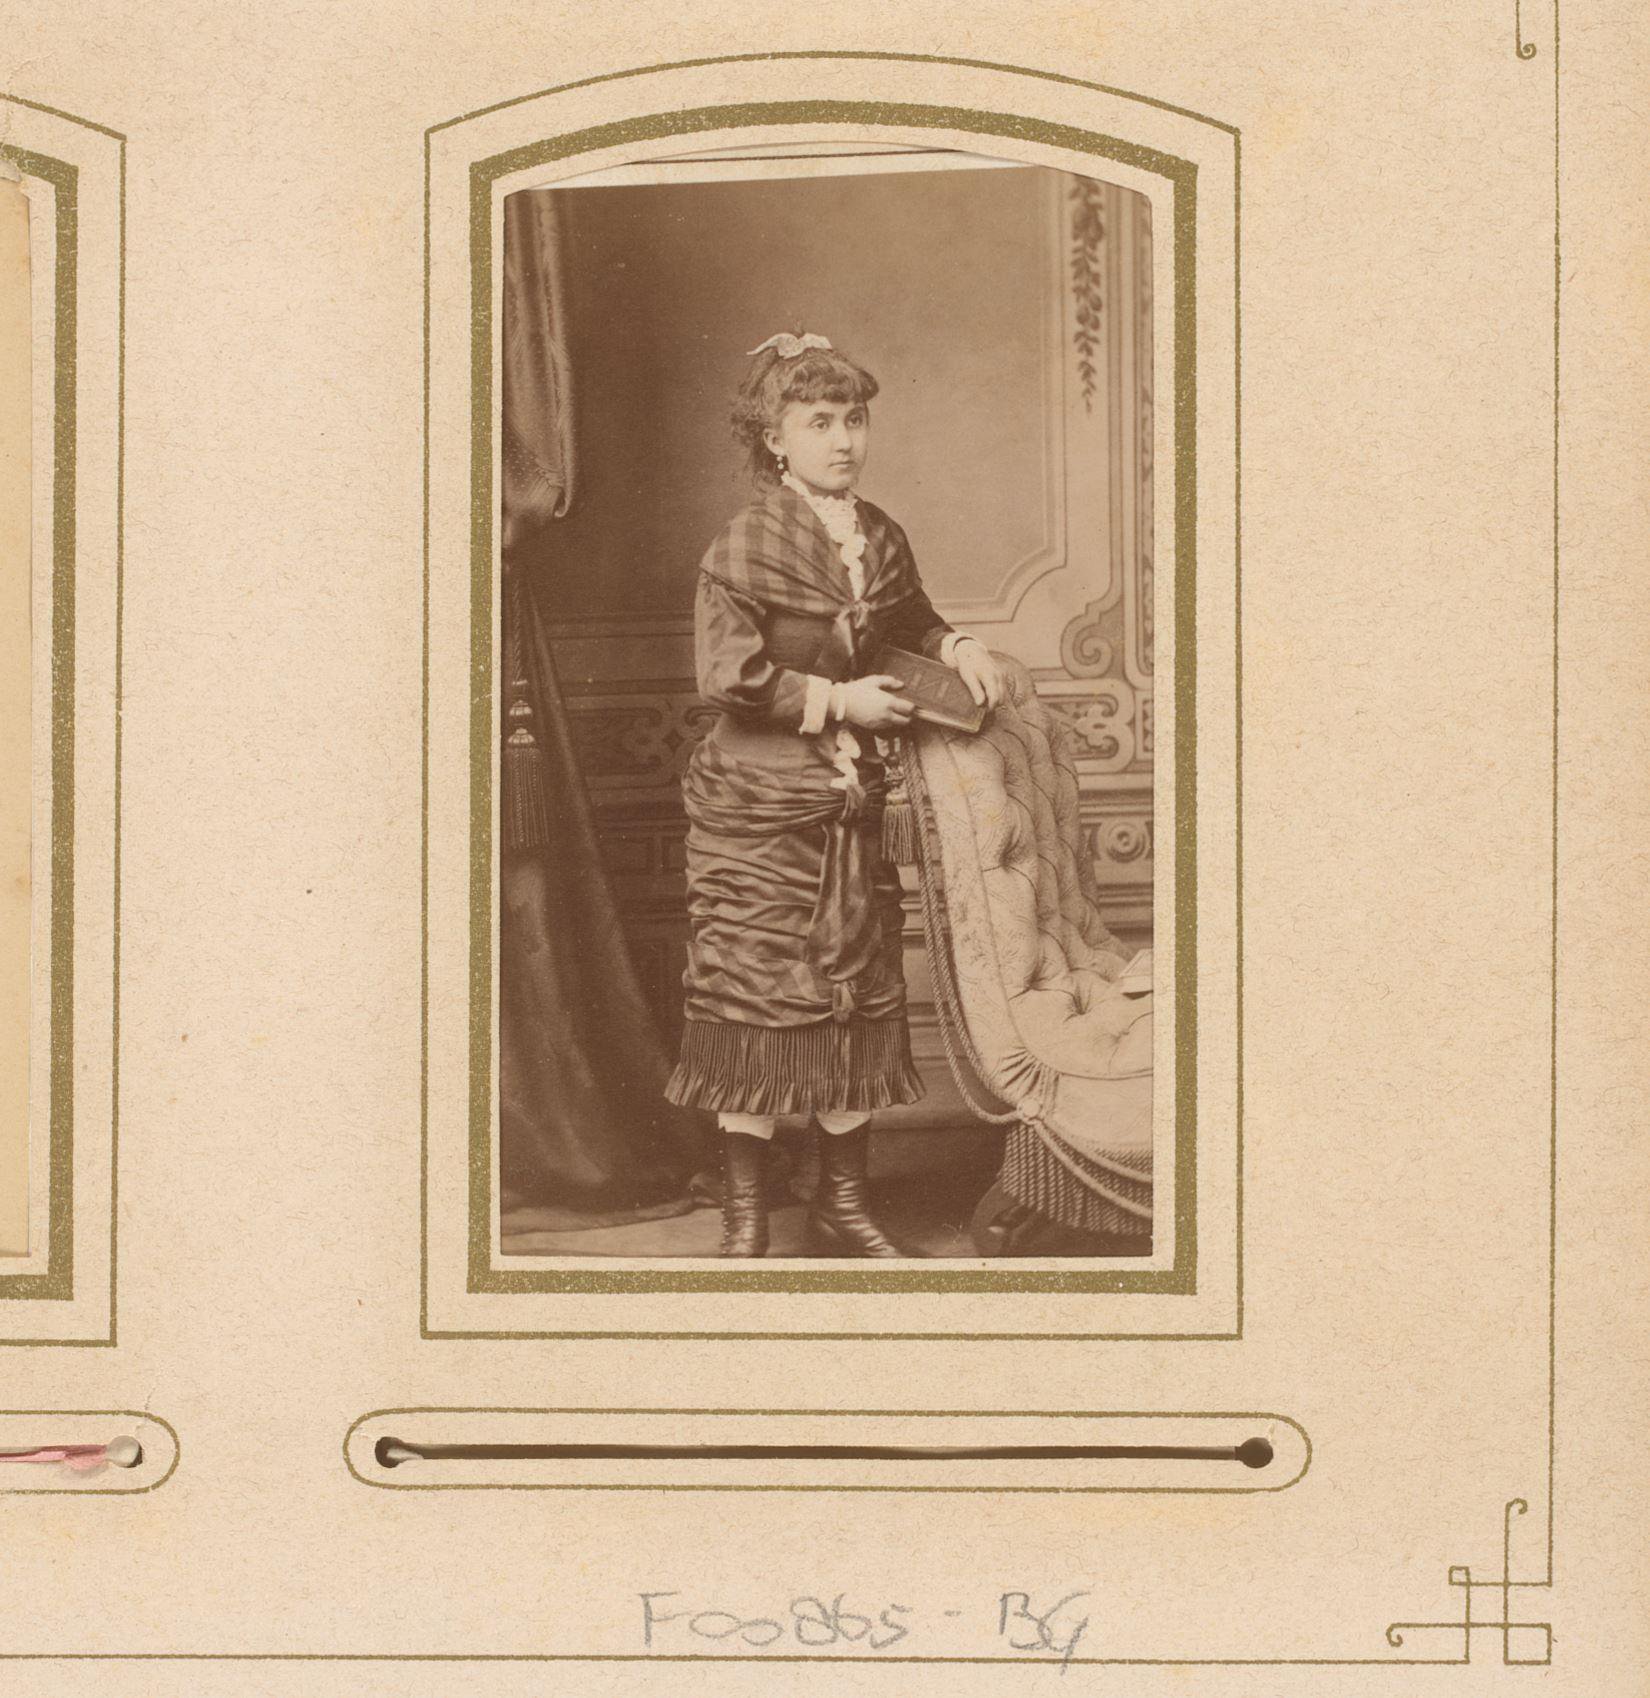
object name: album leaf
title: Portret van een meisje met boek in de hand, staand bij een fauteuil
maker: wilhelm ivens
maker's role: fotograaf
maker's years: 1849-1904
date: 1867-1904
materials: cardboard, photographic support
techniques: albumen print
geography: nijmegen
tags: historical persons - bb - woman, girl (child between toddler and youth), book, chair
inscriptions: inscription: ‘Wilh. Ivens/ NYMEGEN/ 50, Houtstraat 50./ over de Bloemerstraat./ De plaat blyft bewaard.’